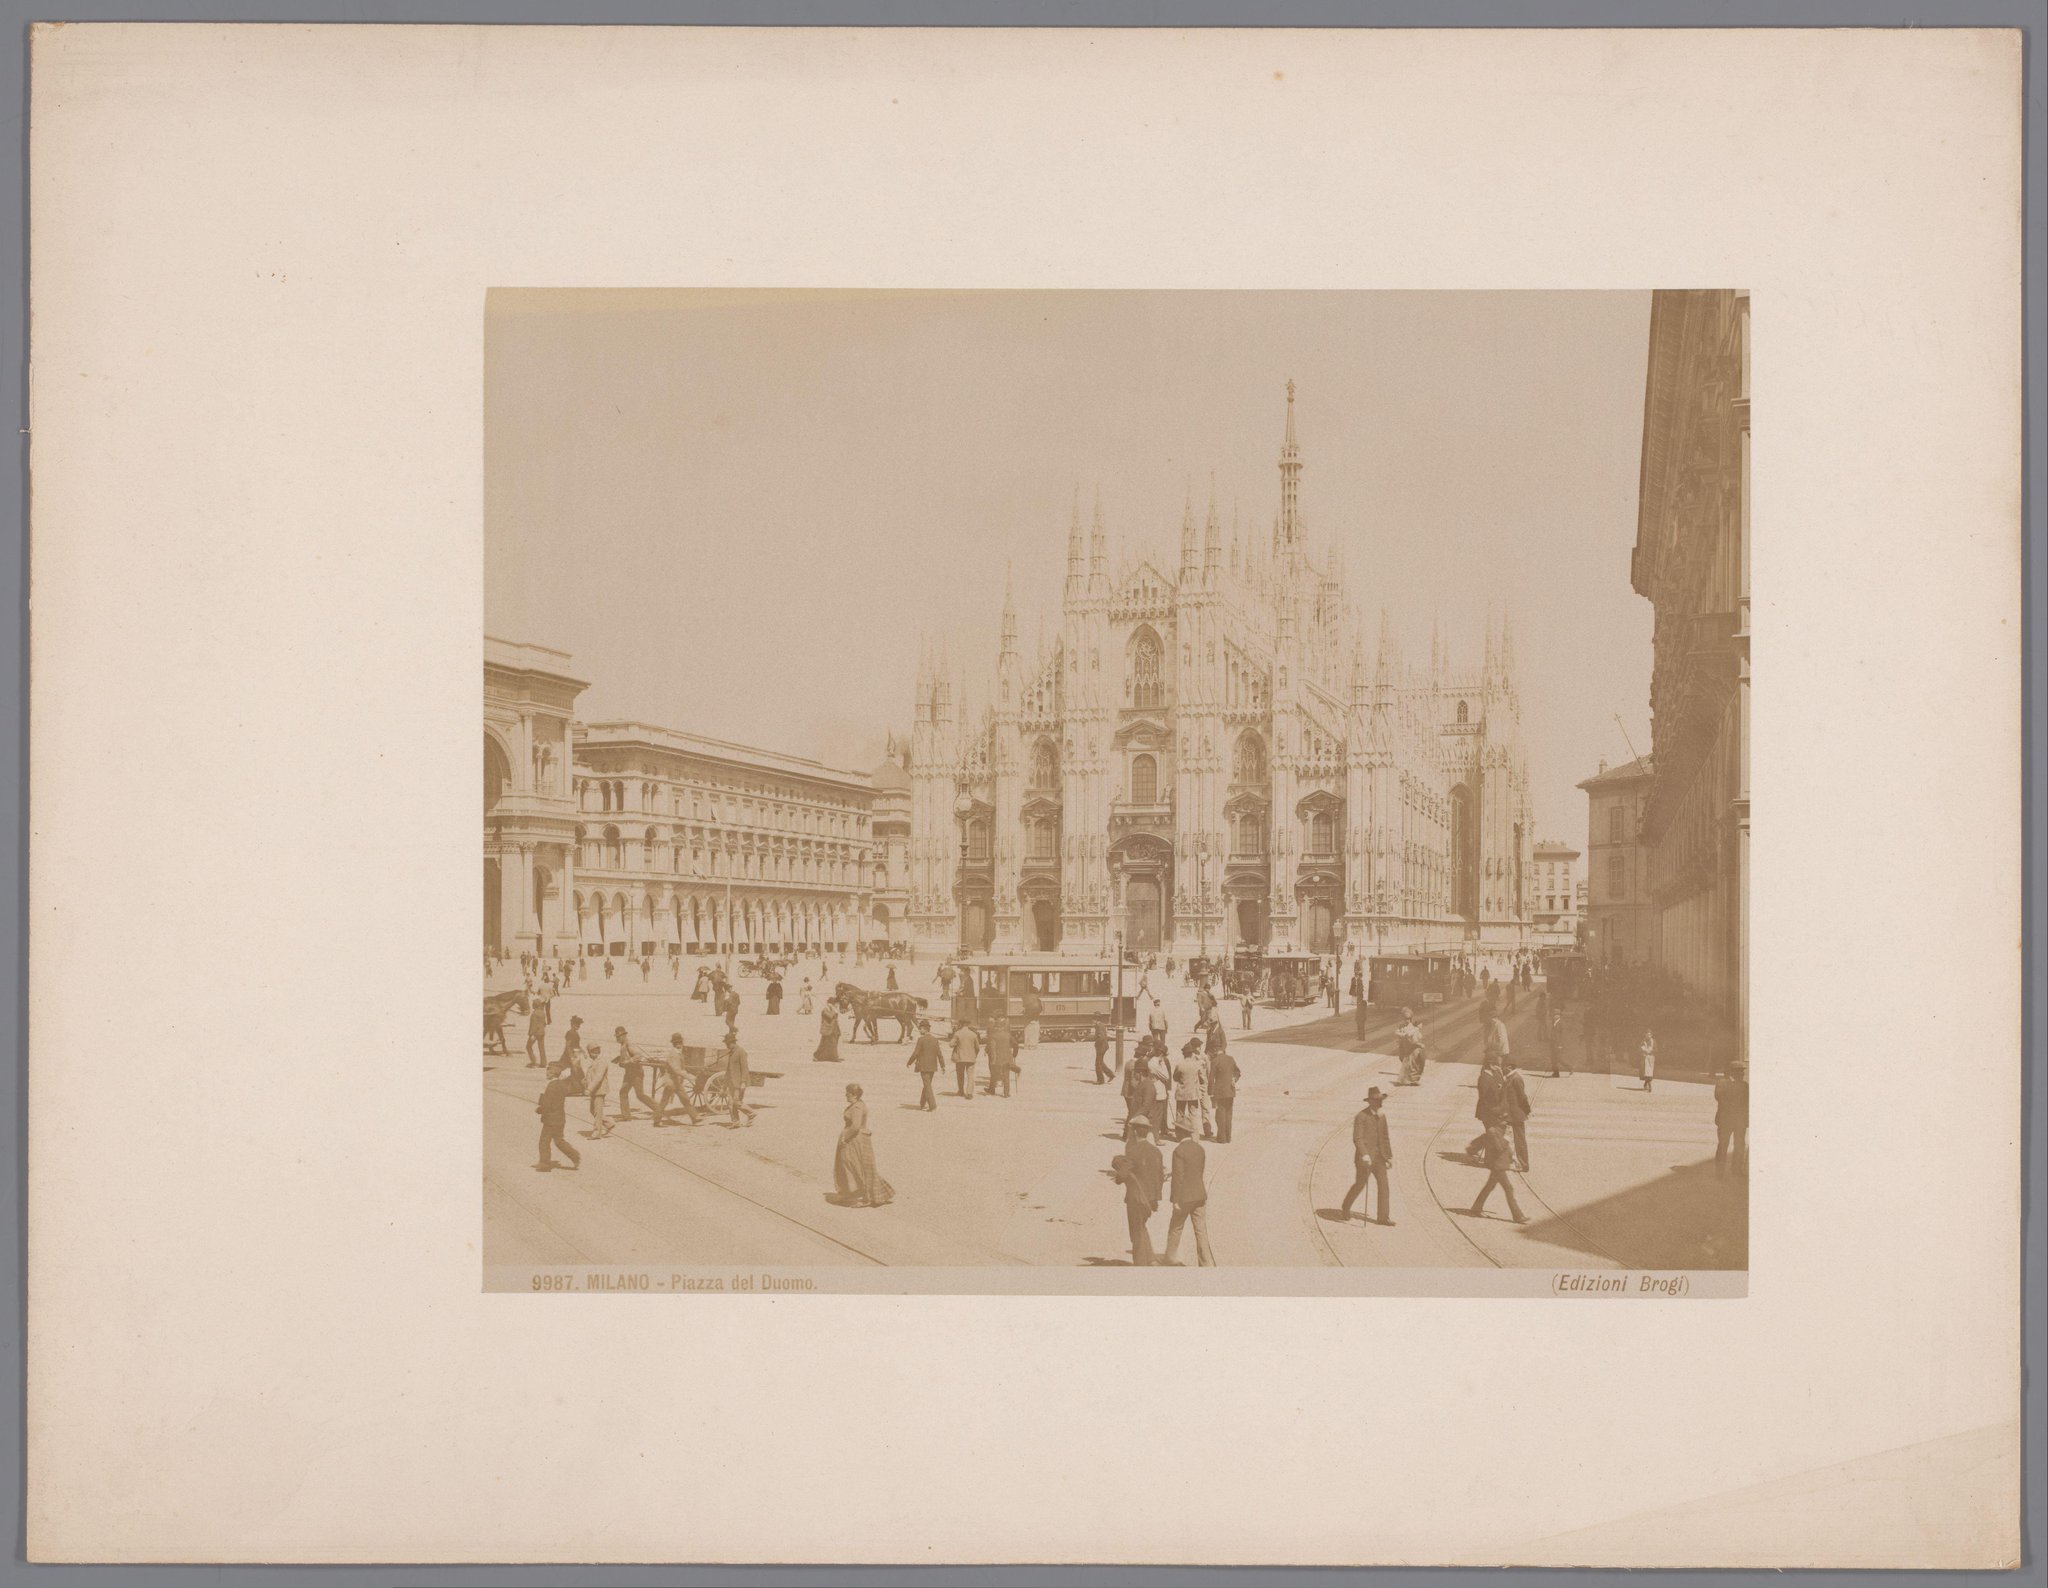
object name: photograph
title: Milano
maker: carlo brogi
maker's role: fotograaf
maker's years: 1850-1925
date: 1881-1900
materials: cardboard, paper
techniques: albumen print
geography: florence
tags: square, place, circus, etc., church (exterior)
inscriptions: number: ‘9987.’